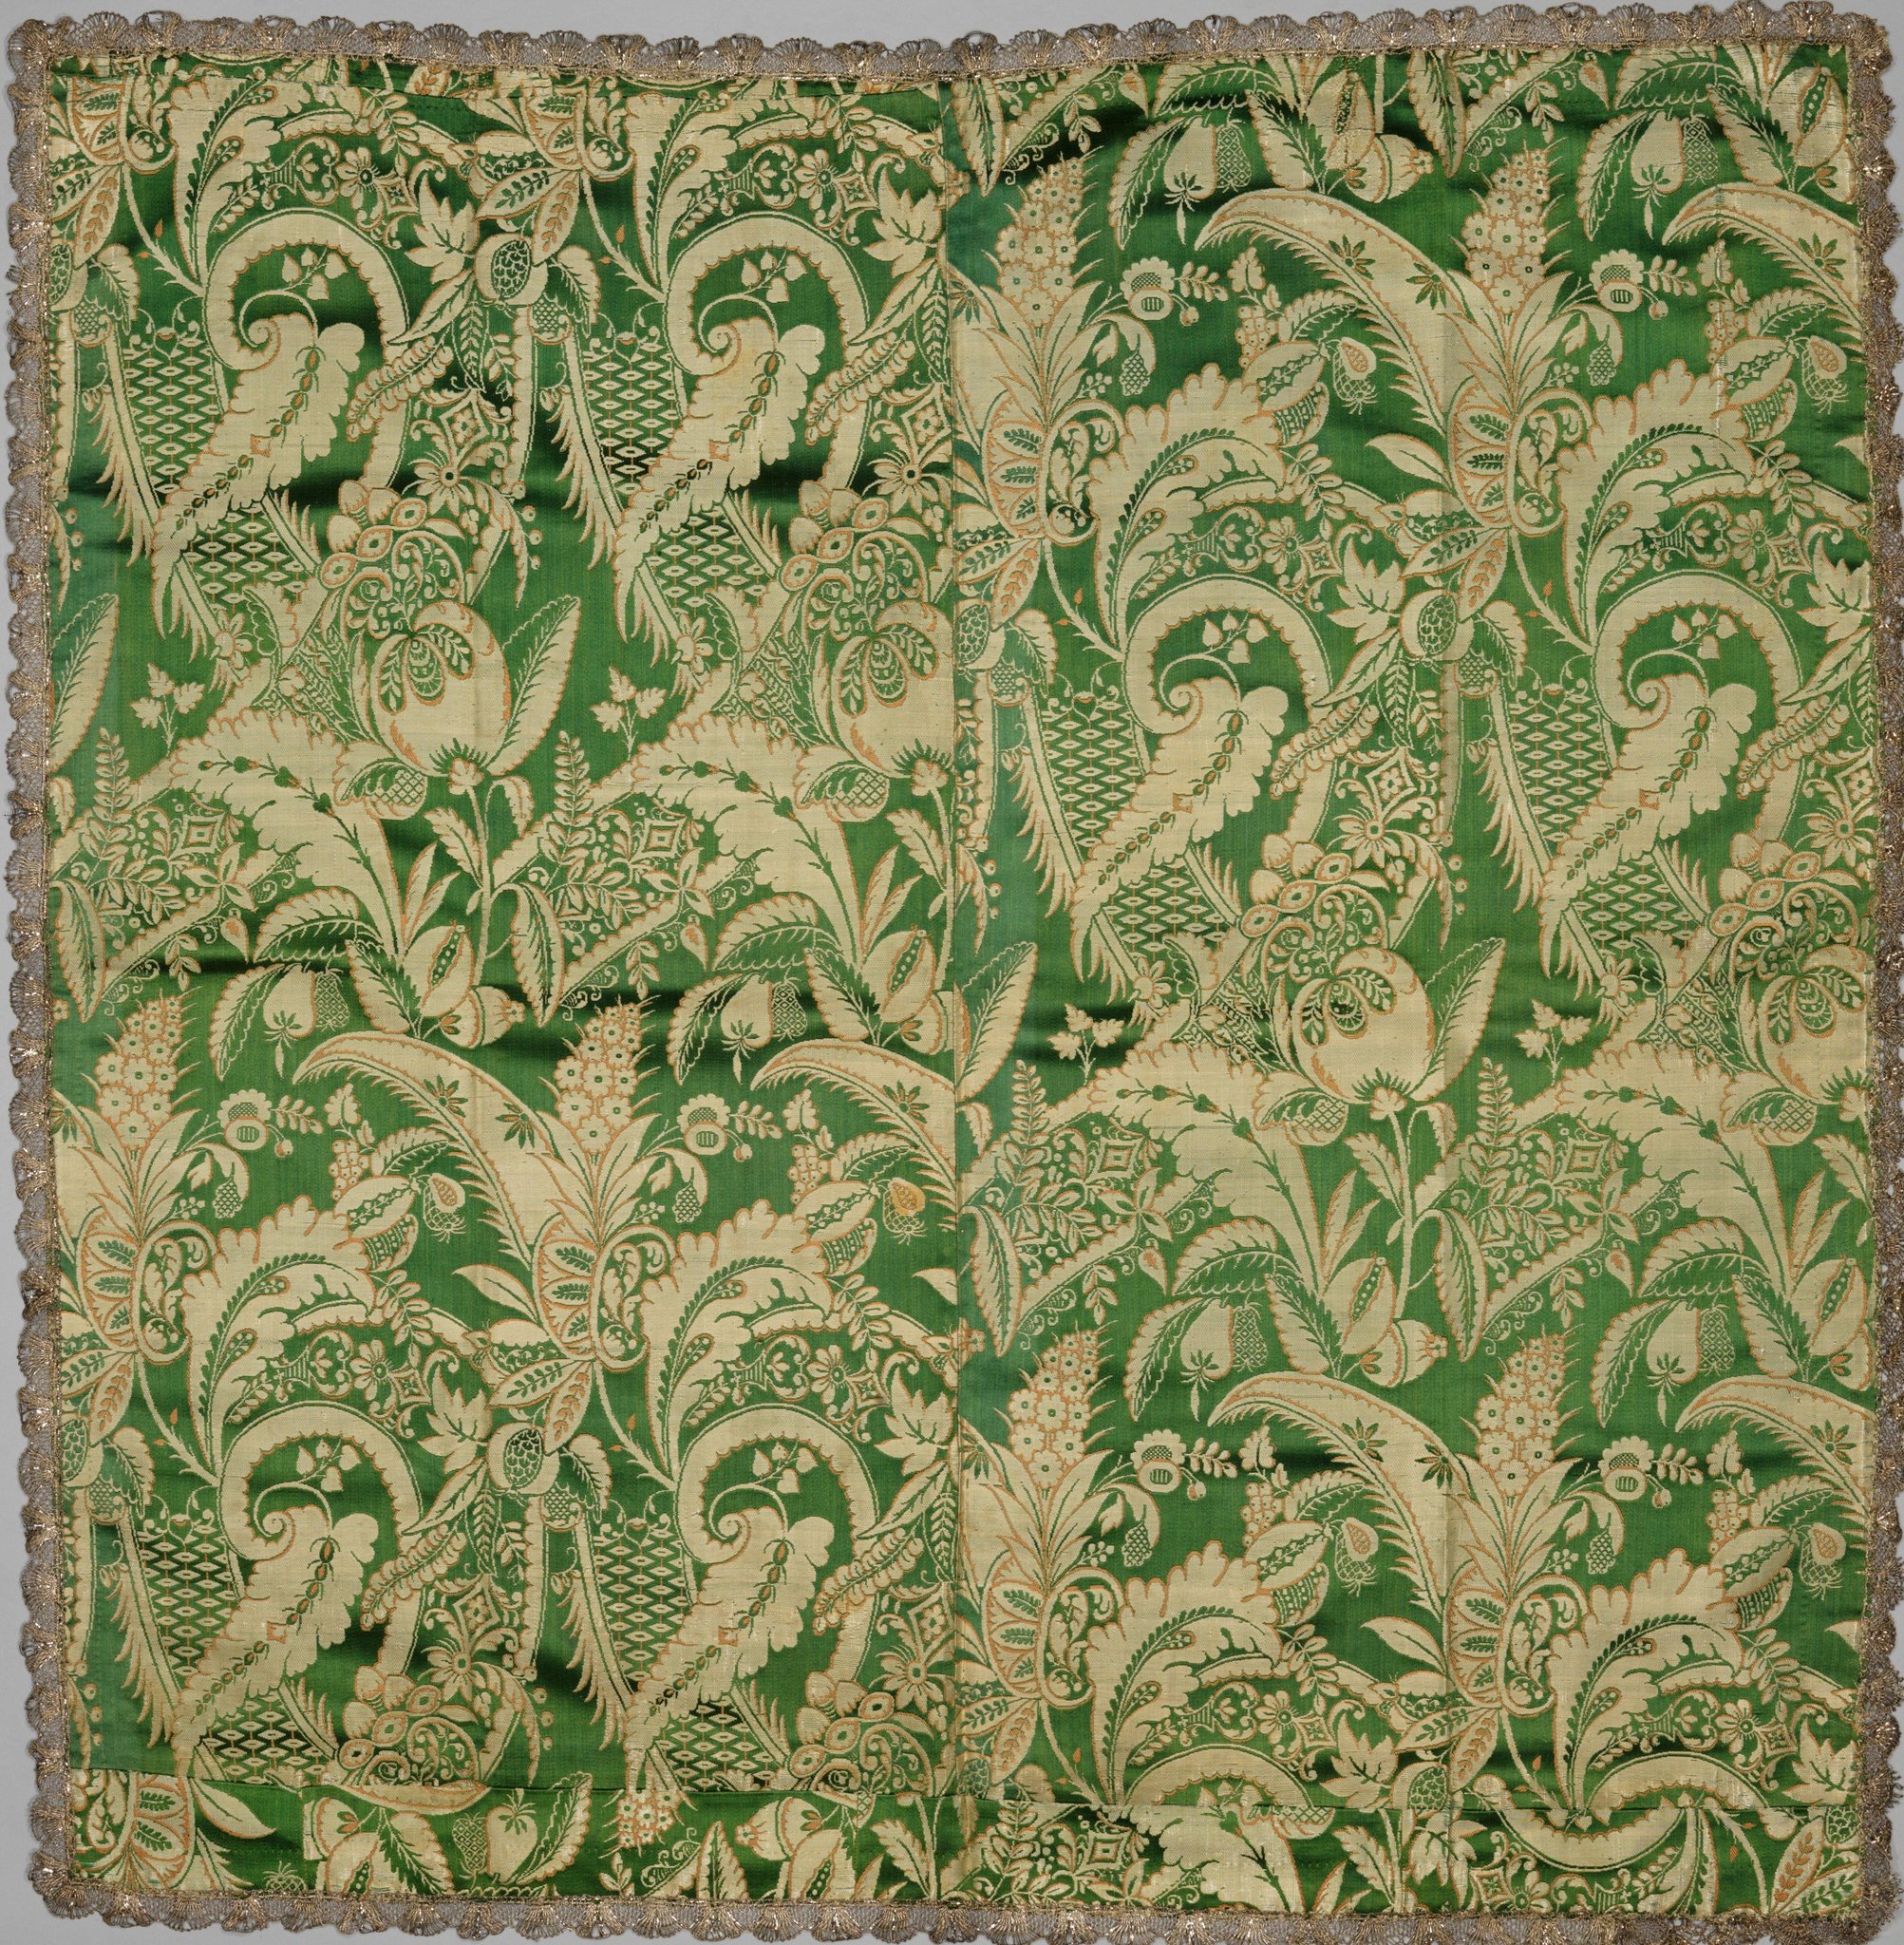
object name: kleed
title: Kleed van zijde met zilverdraad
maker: Anonymous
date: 1700-1799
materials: linen, silk, thread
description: Kleed van zijde met floraal patroon in groen, wit en roze, met gelobd zilverkant langs de randen.